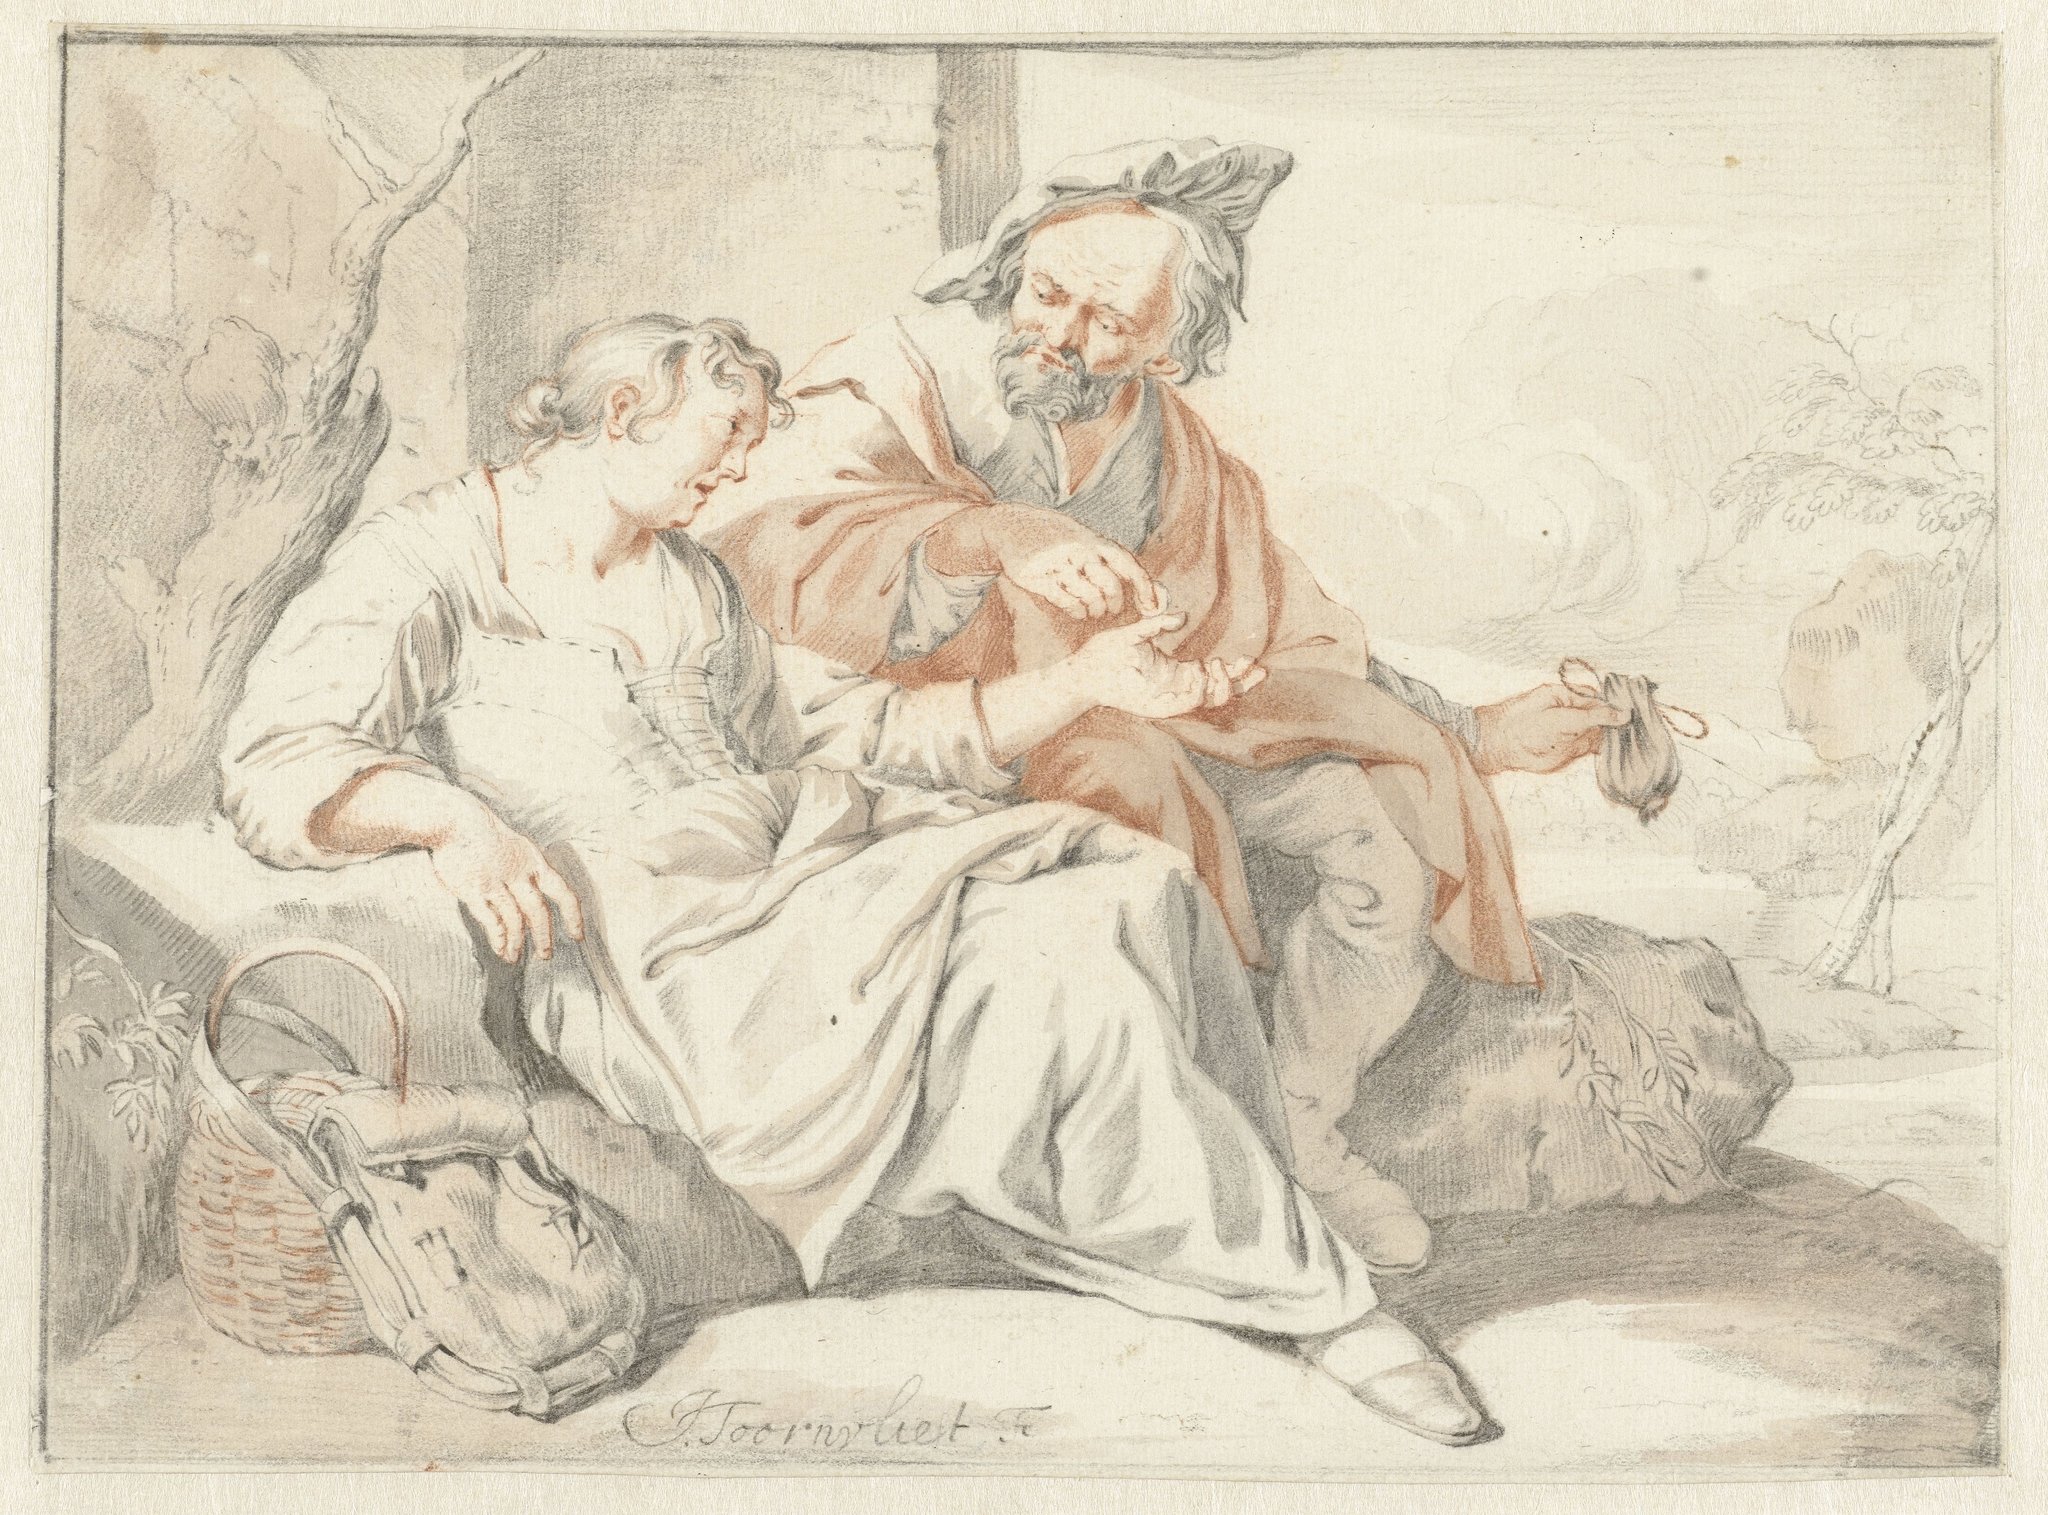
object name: drawing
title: Zittende vrouw neemt geld aan van een man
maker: jacob toorenvliet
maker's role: draughtsman, painter, print maker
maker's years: 1640-1719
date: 1650-1719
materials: chalk, paper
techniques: brush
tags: female sex; woman, pursuit of a woman, prowling, buying and selling, male sex; man